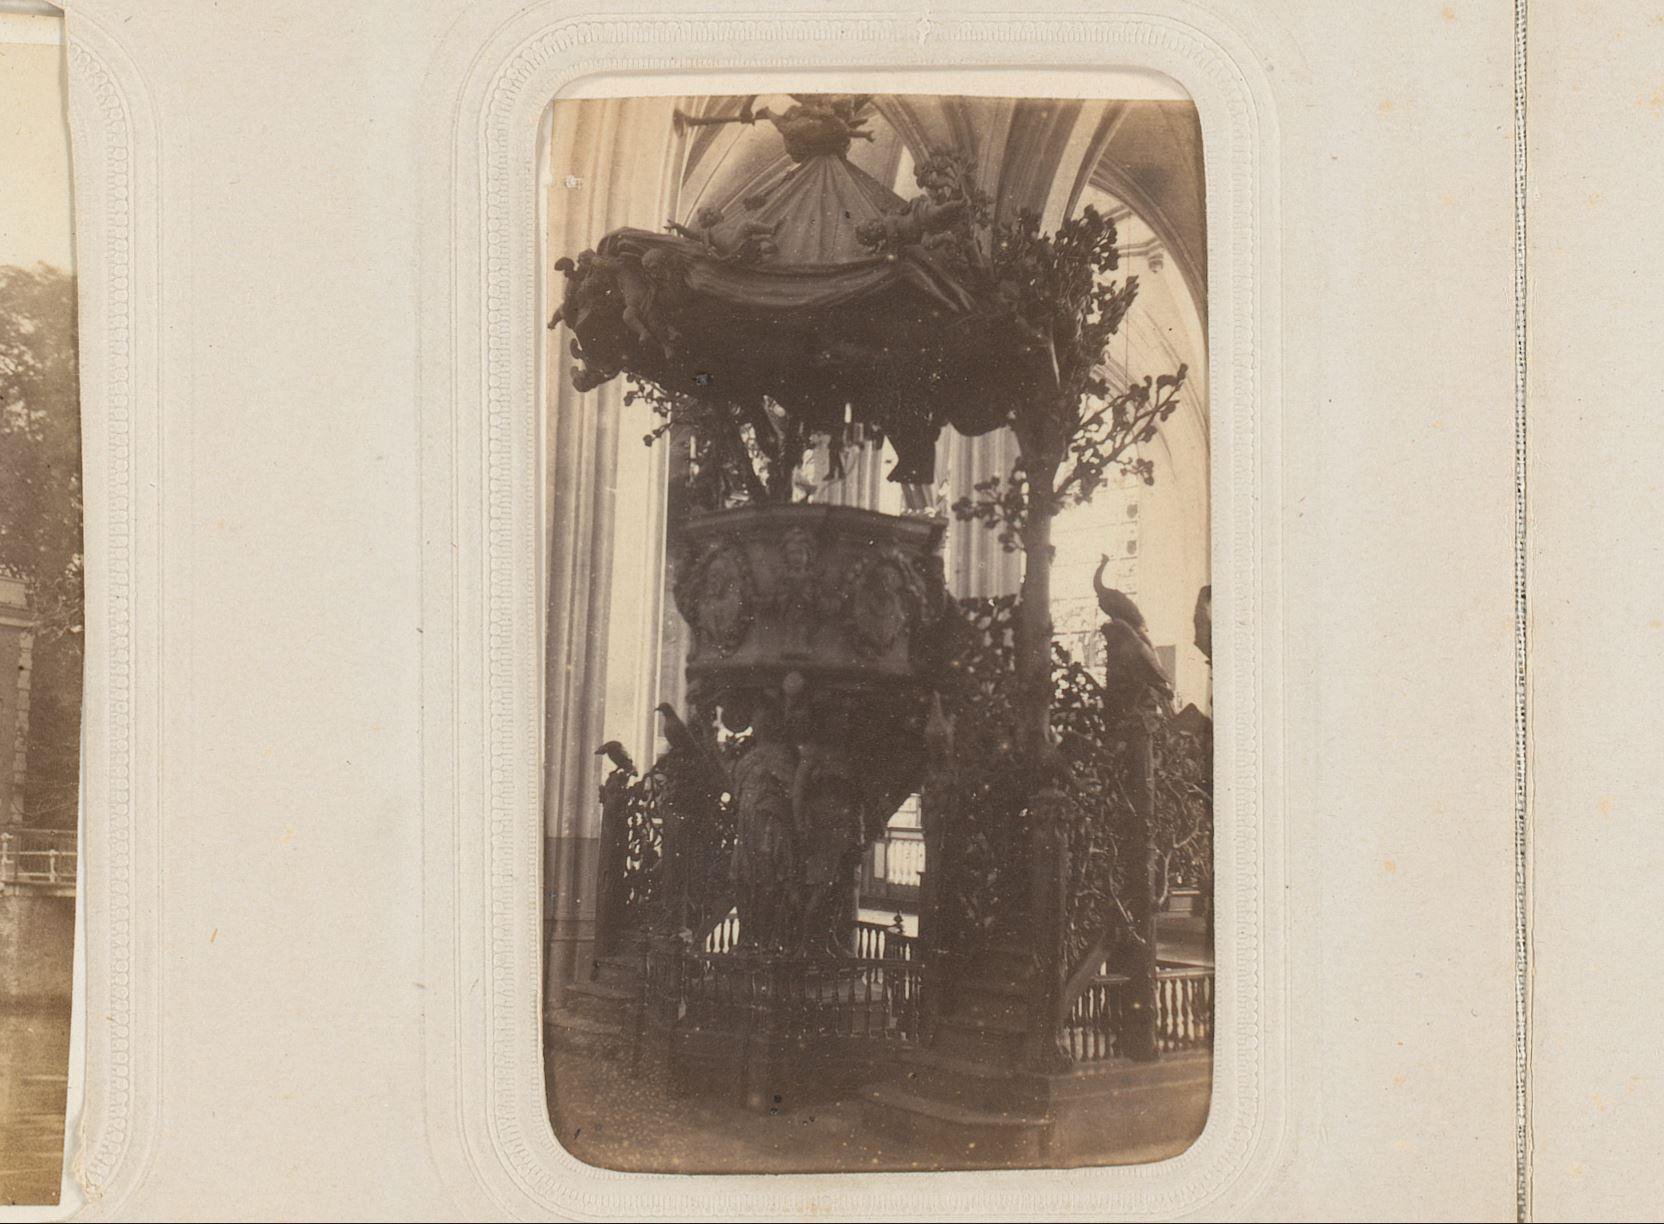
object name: album leaf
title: Preekstoel in de Onze-Lieve-Vrouwekathedraal te Antwerpen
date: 1855-1877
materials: cardboard, photographic support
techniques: albumen print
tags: pulpit, ambo, chancel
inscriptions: annotation: ‘Chaire de la Cathedrale’, inscription: ‘Ad. Braun/ Photographe/ de/ S. M. L'Empereur/ á Dornach (Ht Rhin)’, annotation: ‘Preekstoel te Antwerpen’, annotation: ‘[...] Anvers’